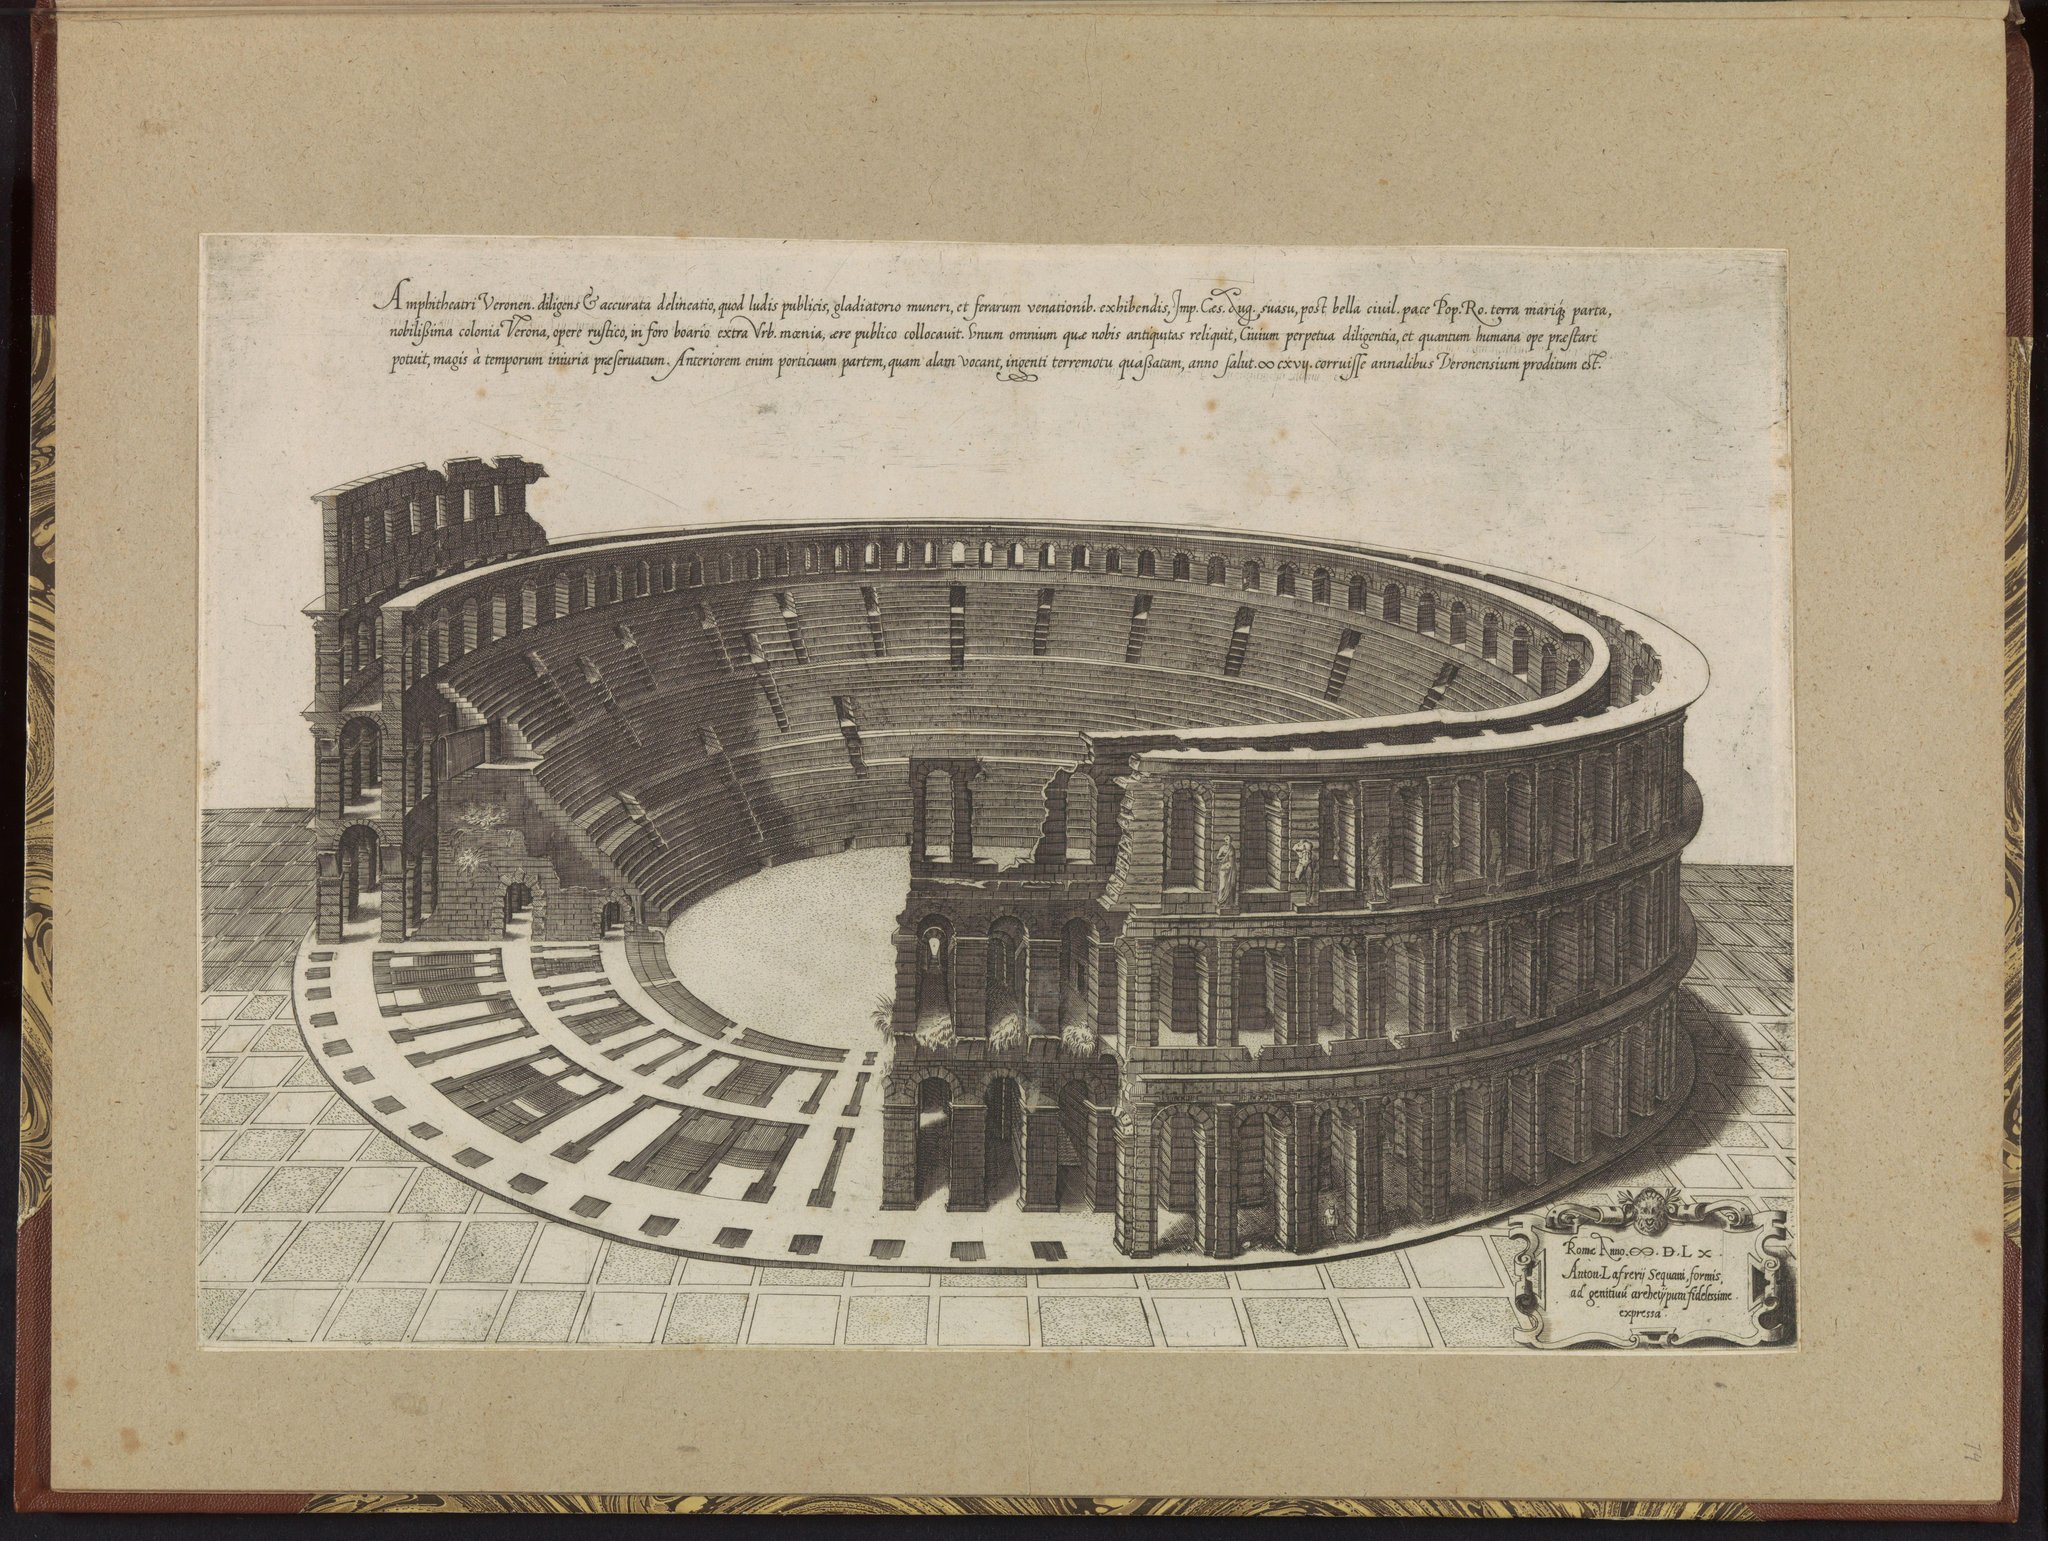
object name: print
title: Speculum Romanae Magnificentiae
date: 1560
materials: paper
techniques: engraving, etching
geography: italy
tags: theatre (building) - aa - open-air performances, representation of real building (either existing or having existed)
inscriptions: date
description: Deze prent behoort tot het prentcorpus dat bekend staat als de ‘Speculum Romanae Magnificentiae’ (‘Spiegel van Romeinse pracht’). Dit corpus, bestaande uit prenten met voorstellingen van kunstwerken en gebouwen uit het antieke en het moderne Rome, vond zijn oorsprong bij uitgevers Antonio Salamanca en Antonio Lafreri. Deze twee buitenlandse uitgevers bundelden hun krachten te Rome in de periode 1553-1563. Hun prenten werden al snel razend populair bij toeristen en verzamelaars, die de prenten individueel of in grote groepen aanschaften. Grote groepen Speculum-prenten werden vaak op aanvraag samengebonden in albums. Er zijn verschillende Speculum-albums overgeleverd die allemaal verschillen van inhoud. Tussen 1573 en 1577 gaf Antonio Lafreri een speciale titelpagina uit (met de titel ‘Speculum Romanae Magnificentiae’) die mensen voor hun verzamelingen konden voegen. Het overlijden van Lafreri in 1577 betekende niet het einde van het corpus. Een groot deel van de koperplaten ging over op Claudio en Stefano Duchetti. De rest raakte verspreid over verschillende andere uitgevers. De populariteit van de Speculum-prenten wist nog geruime periode uitgevers te inspireren tot het laten maken van kopieën en het toevoegen van nieuwe prenten aan het corpus.